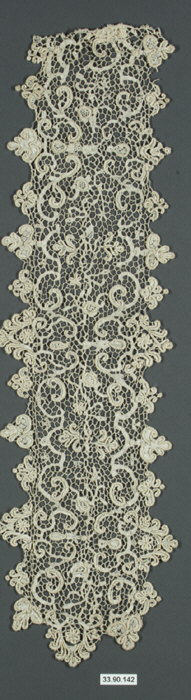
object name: lappet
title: Lappet (one of a pair)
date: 1701-1733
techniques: lace